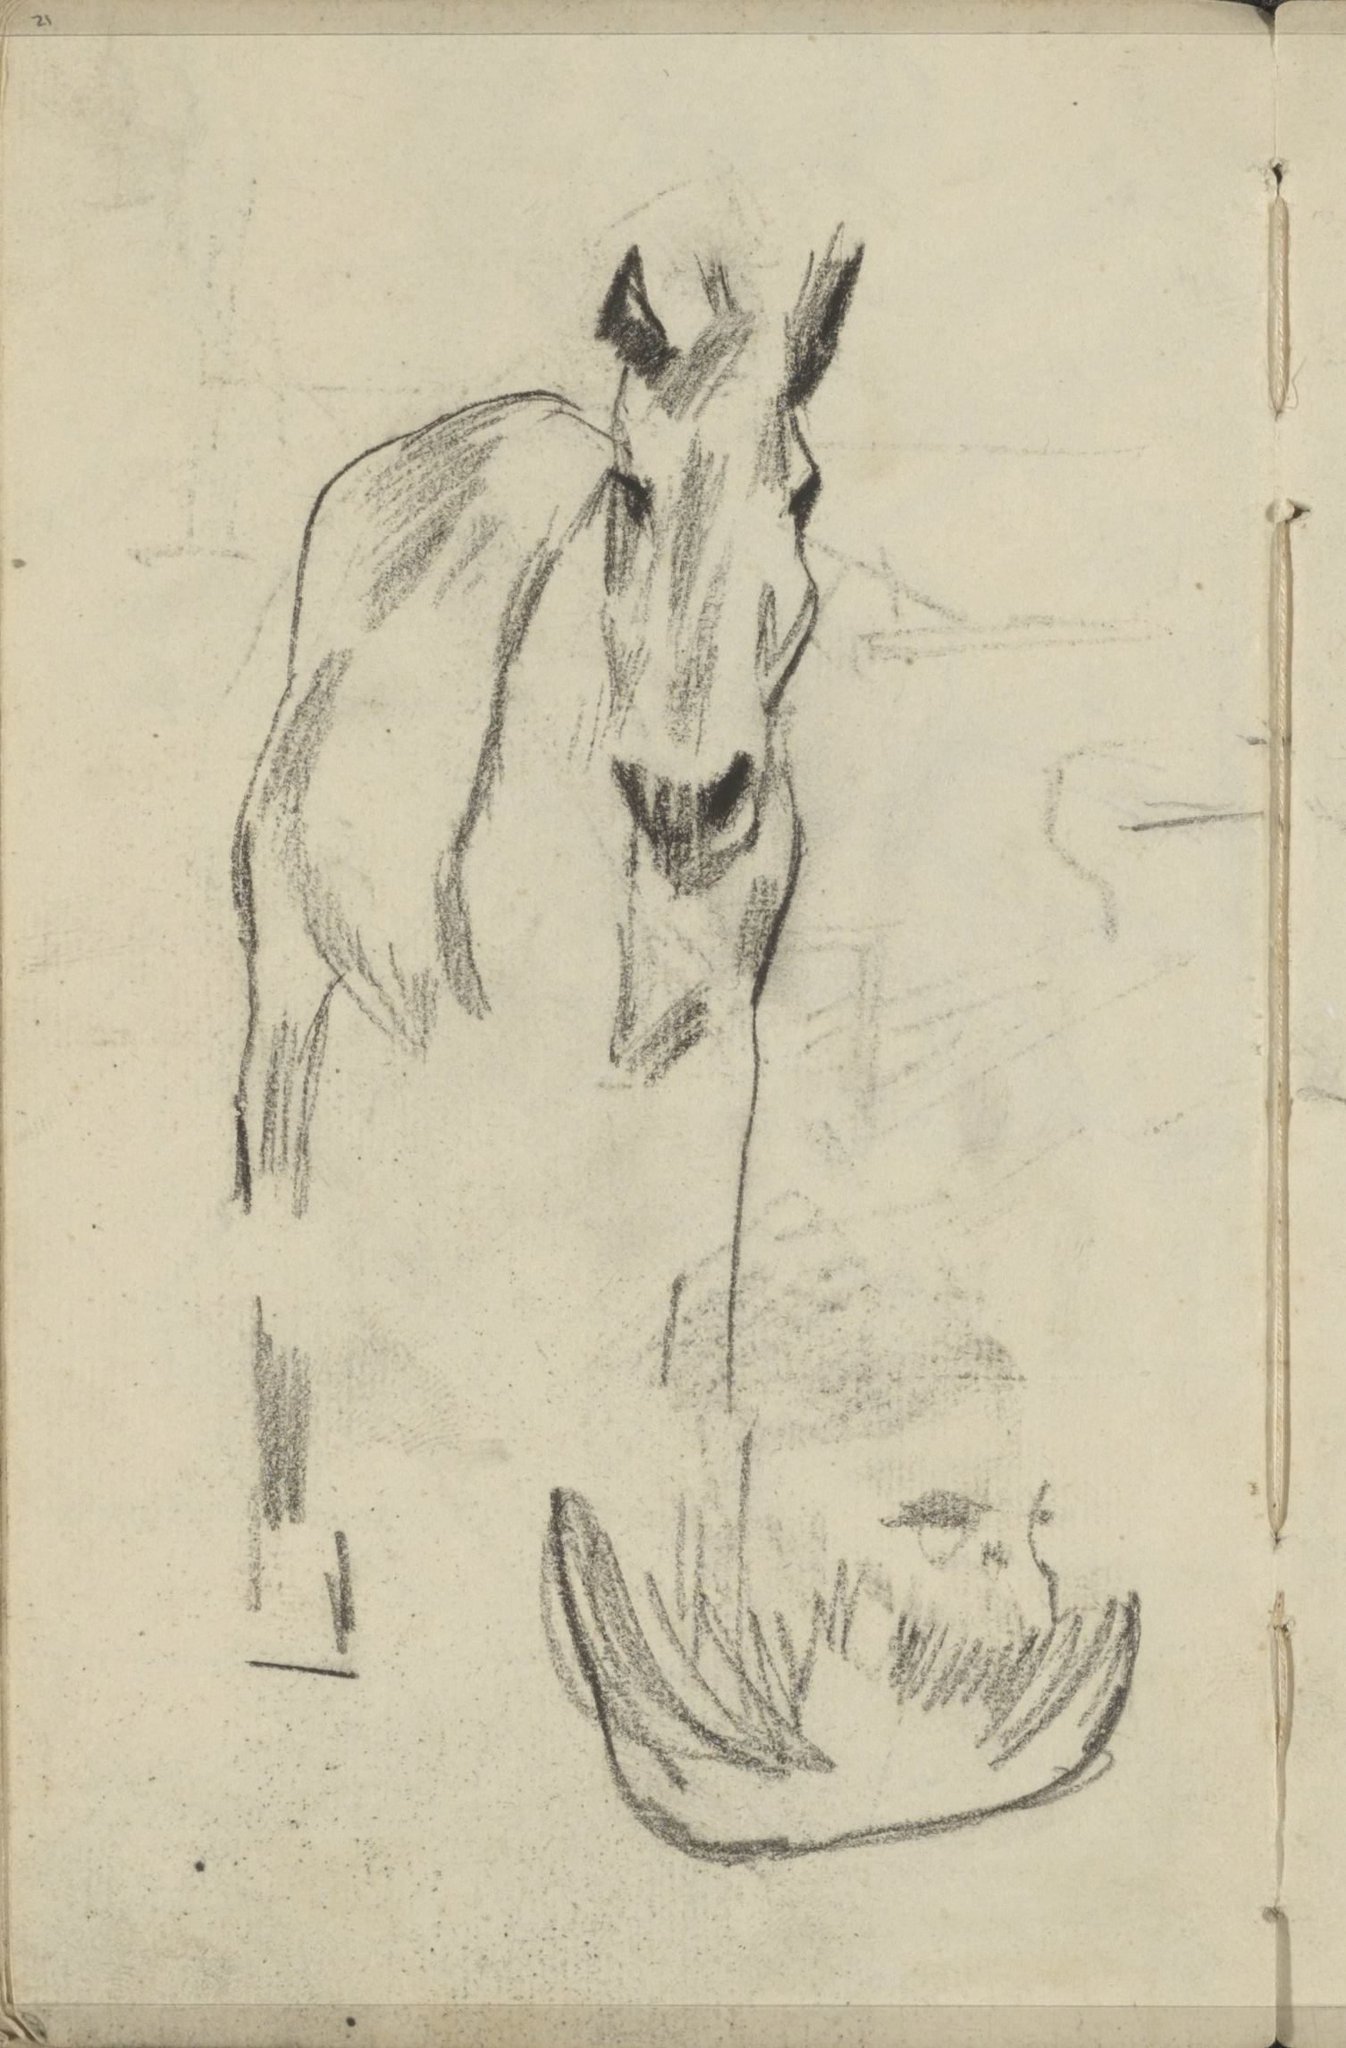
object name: sketchbook leaf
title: Hoofd in profiel en een paard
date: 1883-1885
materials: chalk, paper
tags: head (human) (+ sideview, profile), horse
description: Pagina 21 uit een schetsboek met 16 bladen.